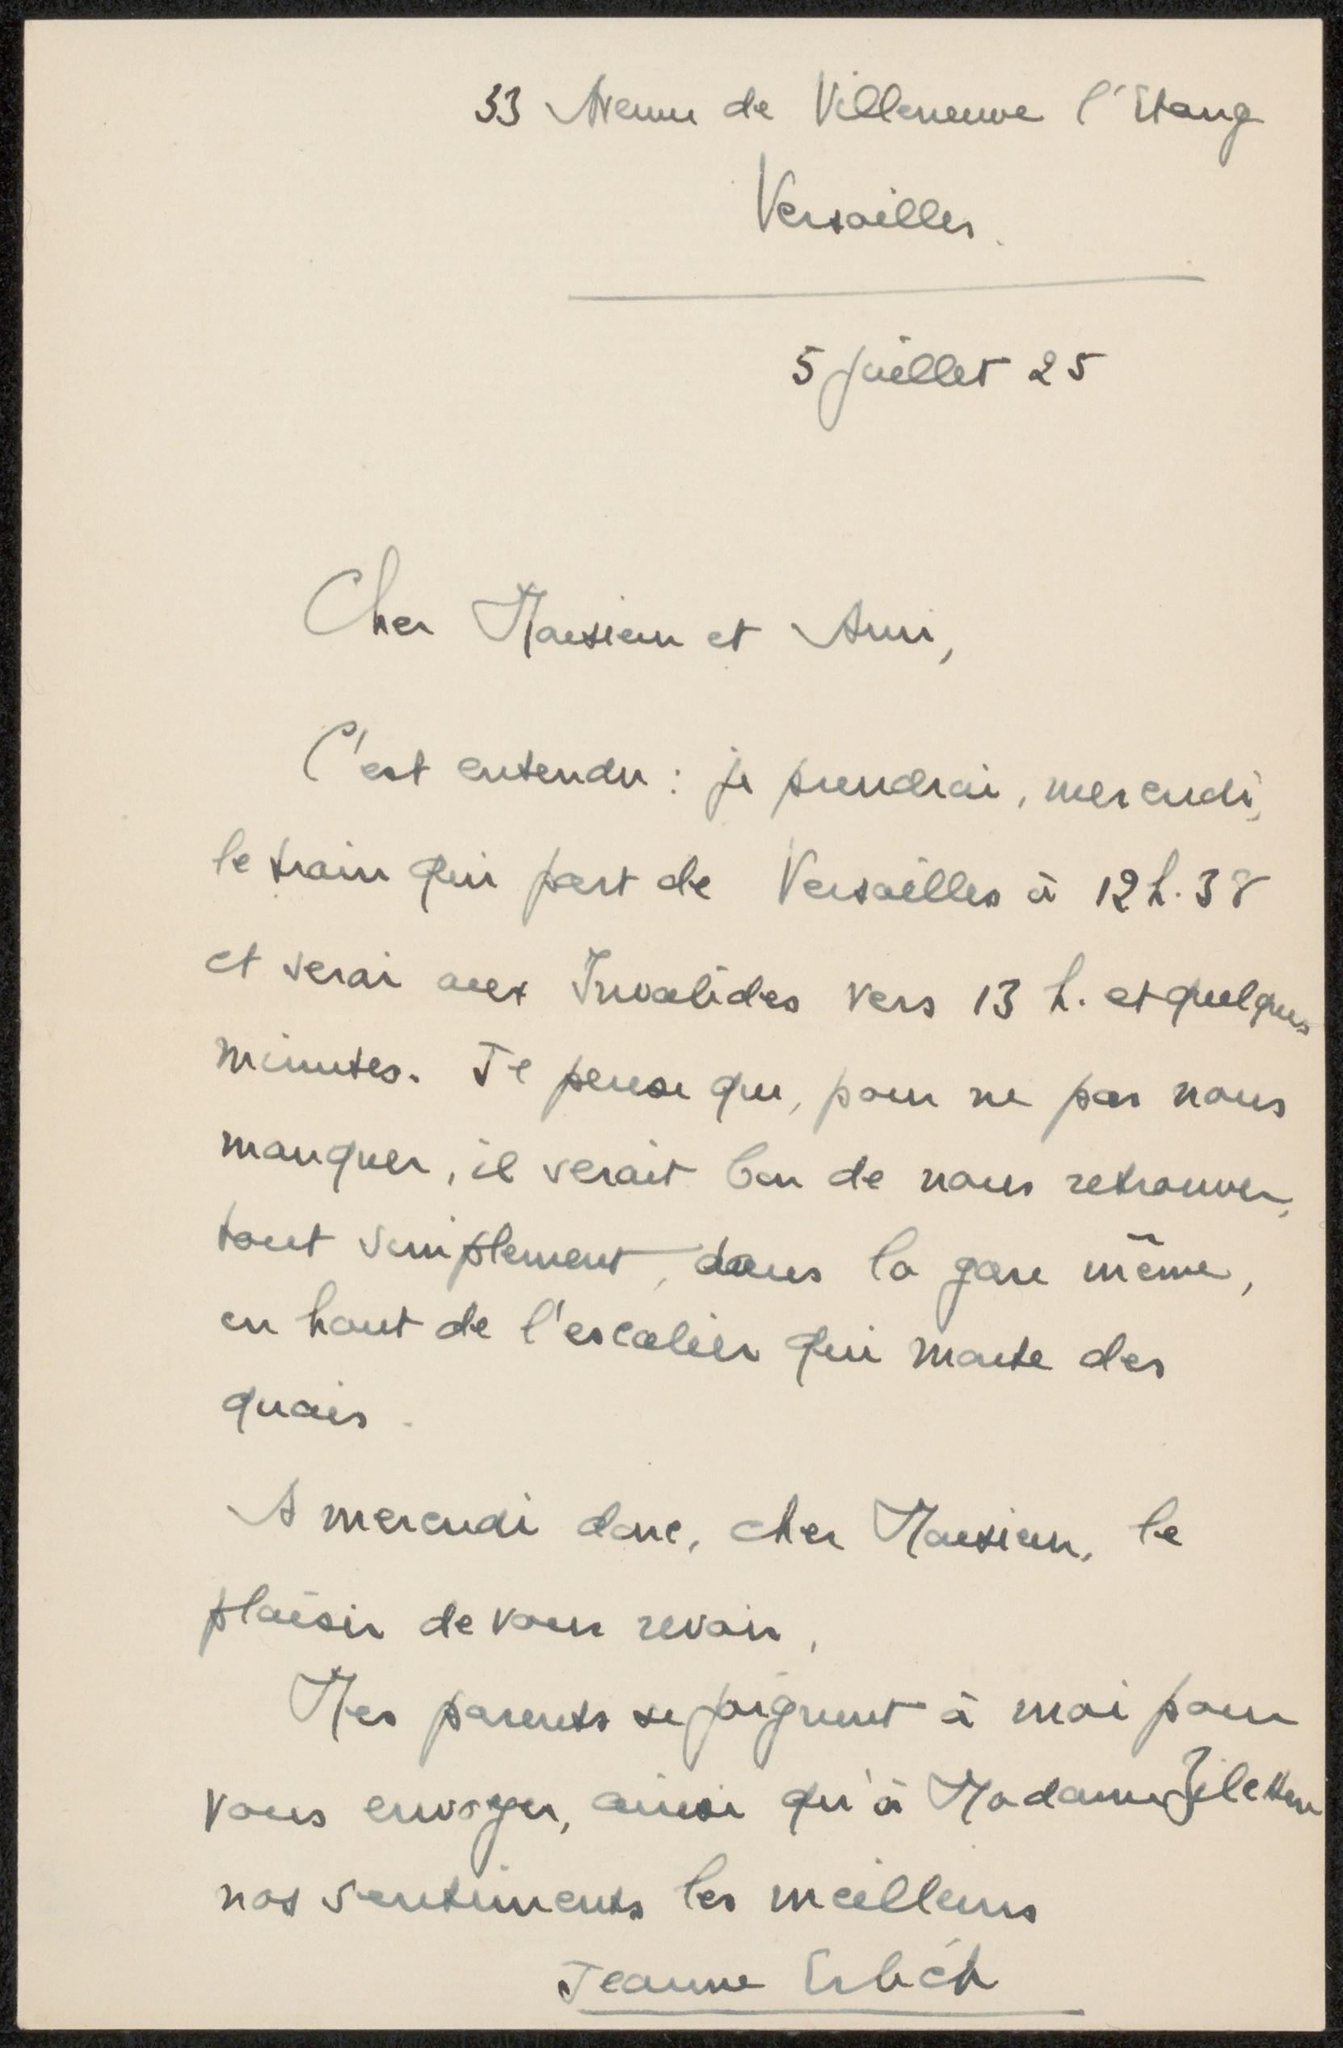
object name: letter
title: Brief aan Philip Zilcken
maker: jeanne erlich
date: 1925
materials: ink, paper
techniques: pen, writing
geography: versailles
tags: the hague, painter, draughtsman, philip zilcken, paris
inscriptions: collector's mark: ‘RPK’, watermark